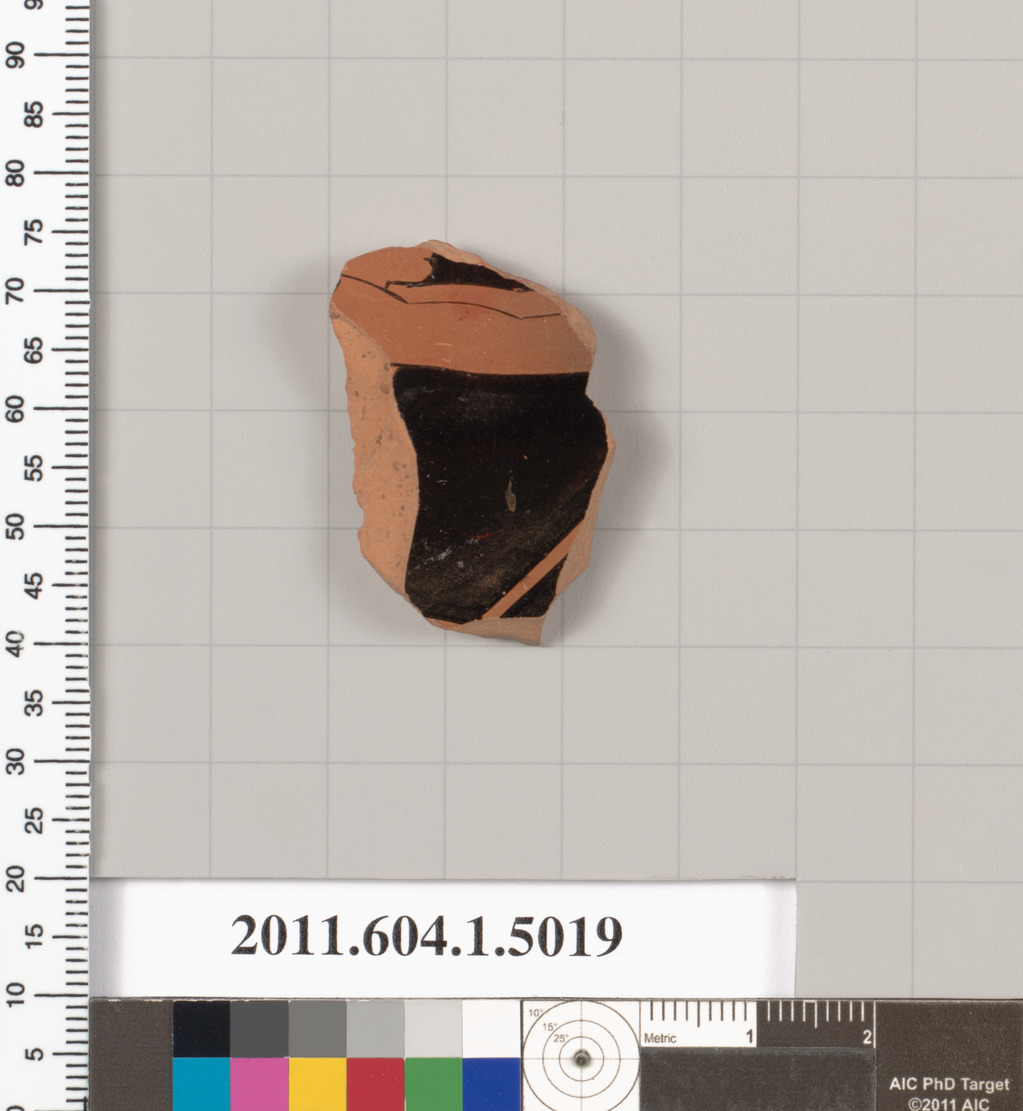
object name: kylix fragment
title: Terracotta fragment of a kylix (drinking cup)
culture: greek, attic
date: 490-480 BCE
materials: terracotta